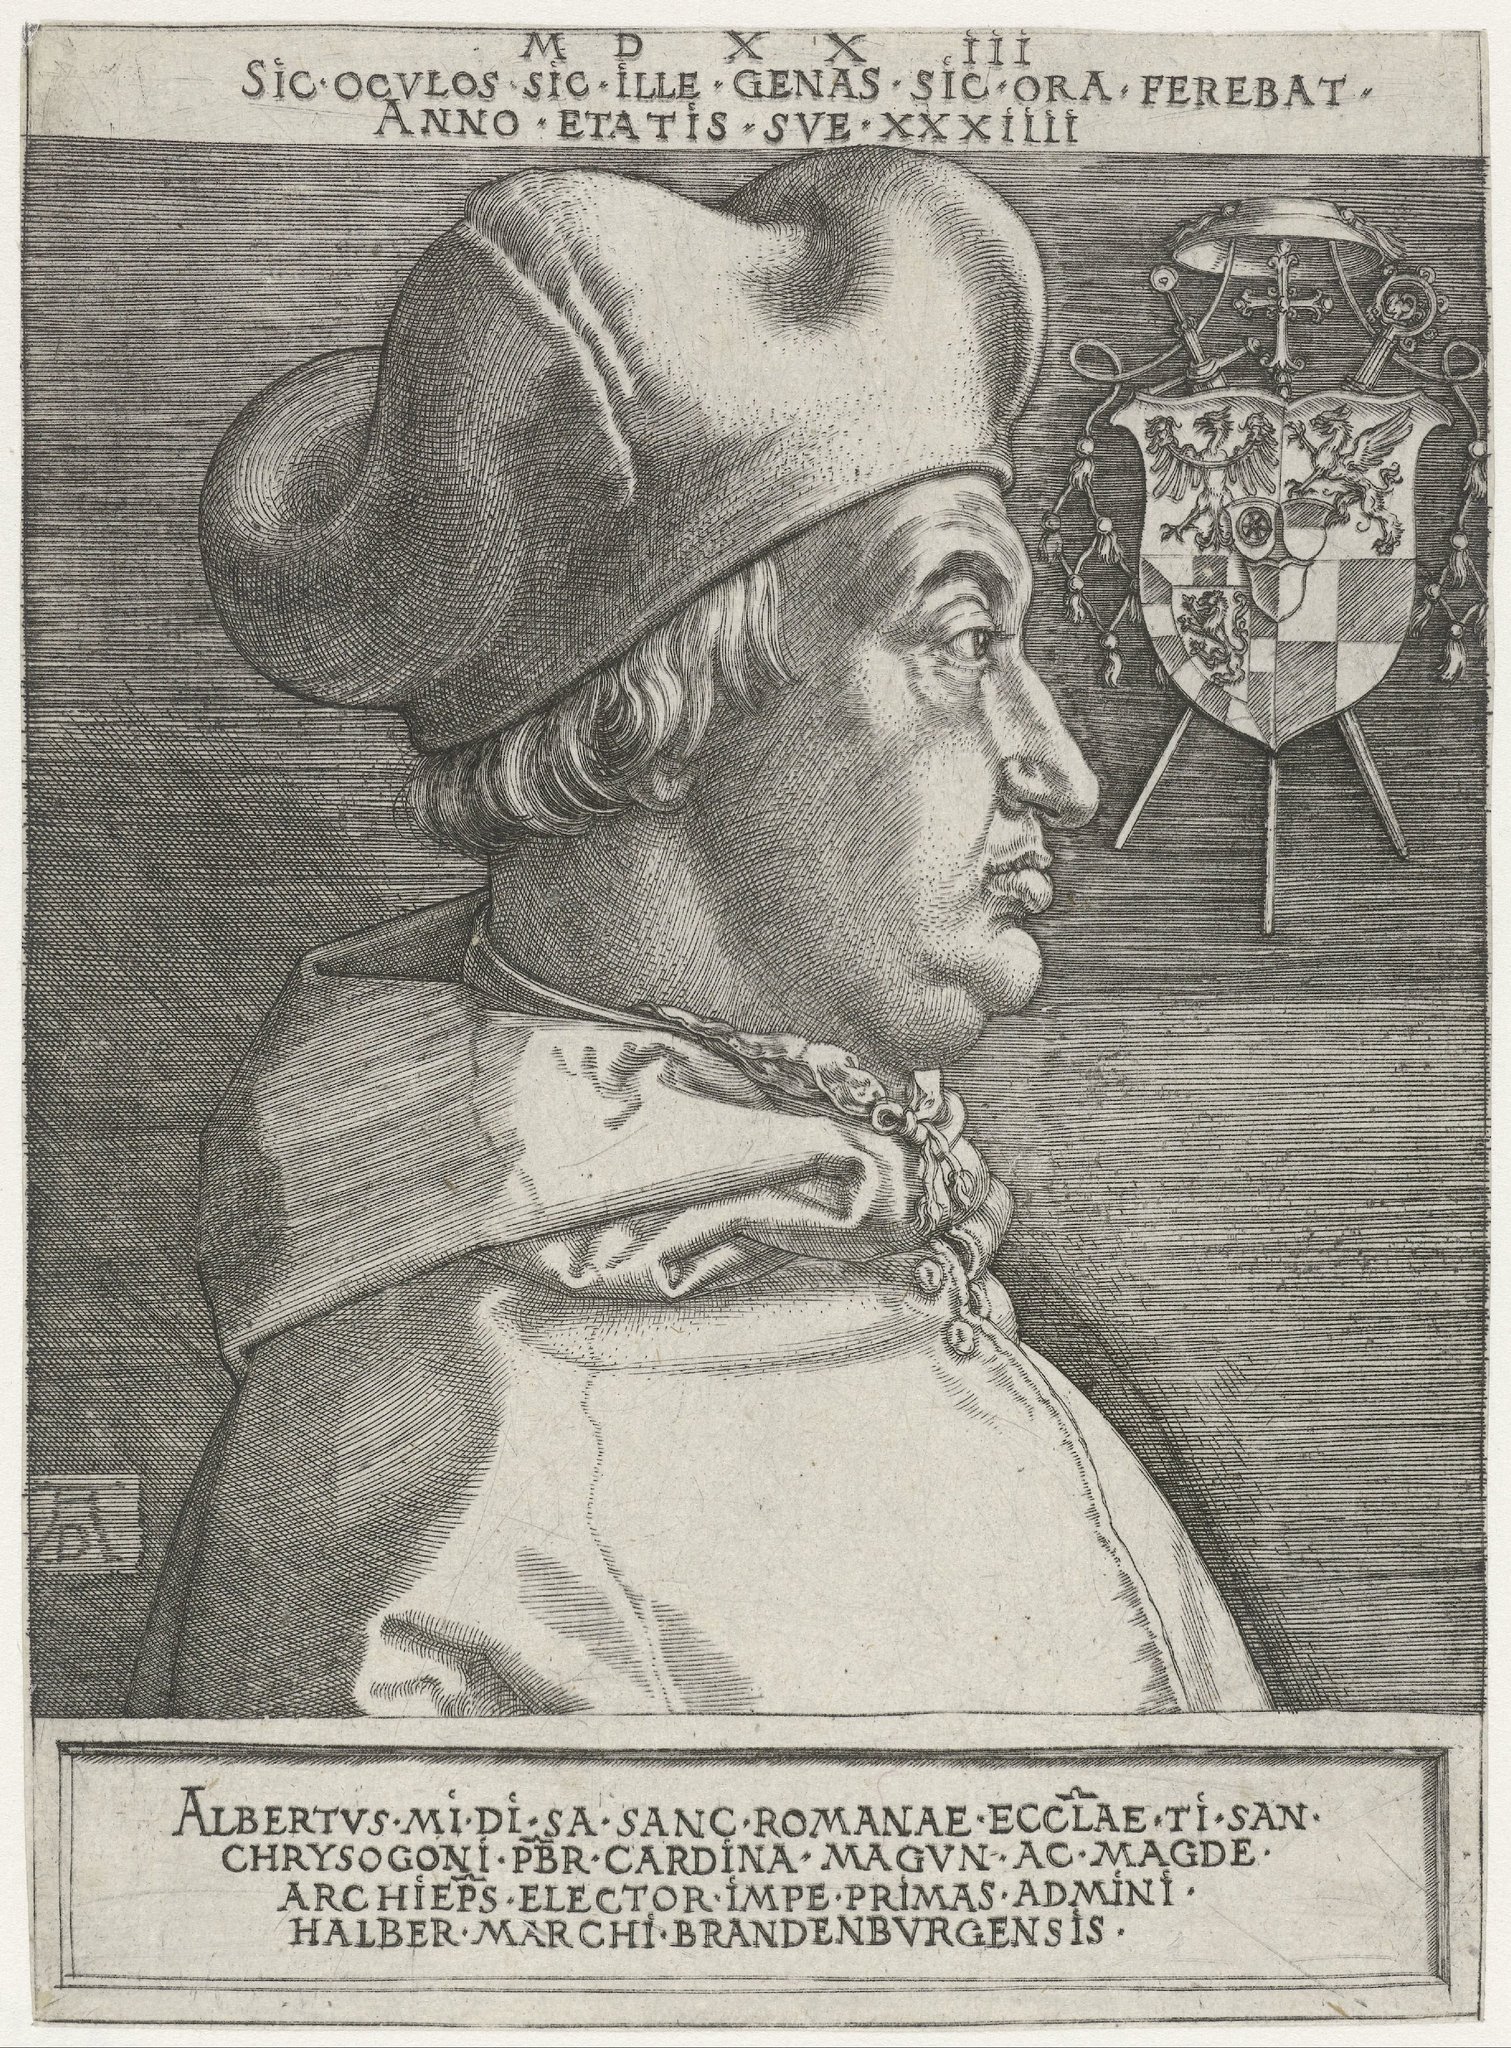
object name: print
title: Portret van kardinaal Albert van Brandenburg op 34-jarige leeftijd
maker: albrecht dürer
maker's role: draughtsman, painter, print maker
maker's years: 1471-1528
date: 1523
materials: paper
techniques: engraving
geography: nuremberg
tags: head-gear (bonnet) (+ men's clothes), cardinal, historical persons, armorial bearing, heraldry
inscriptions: collector's mark: Lugt 240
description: Buste naar rechts, kalotvormige bonnet op het hoofd, gekleed in kardinaalsmantel. Datering kostuum: 1520-1530.